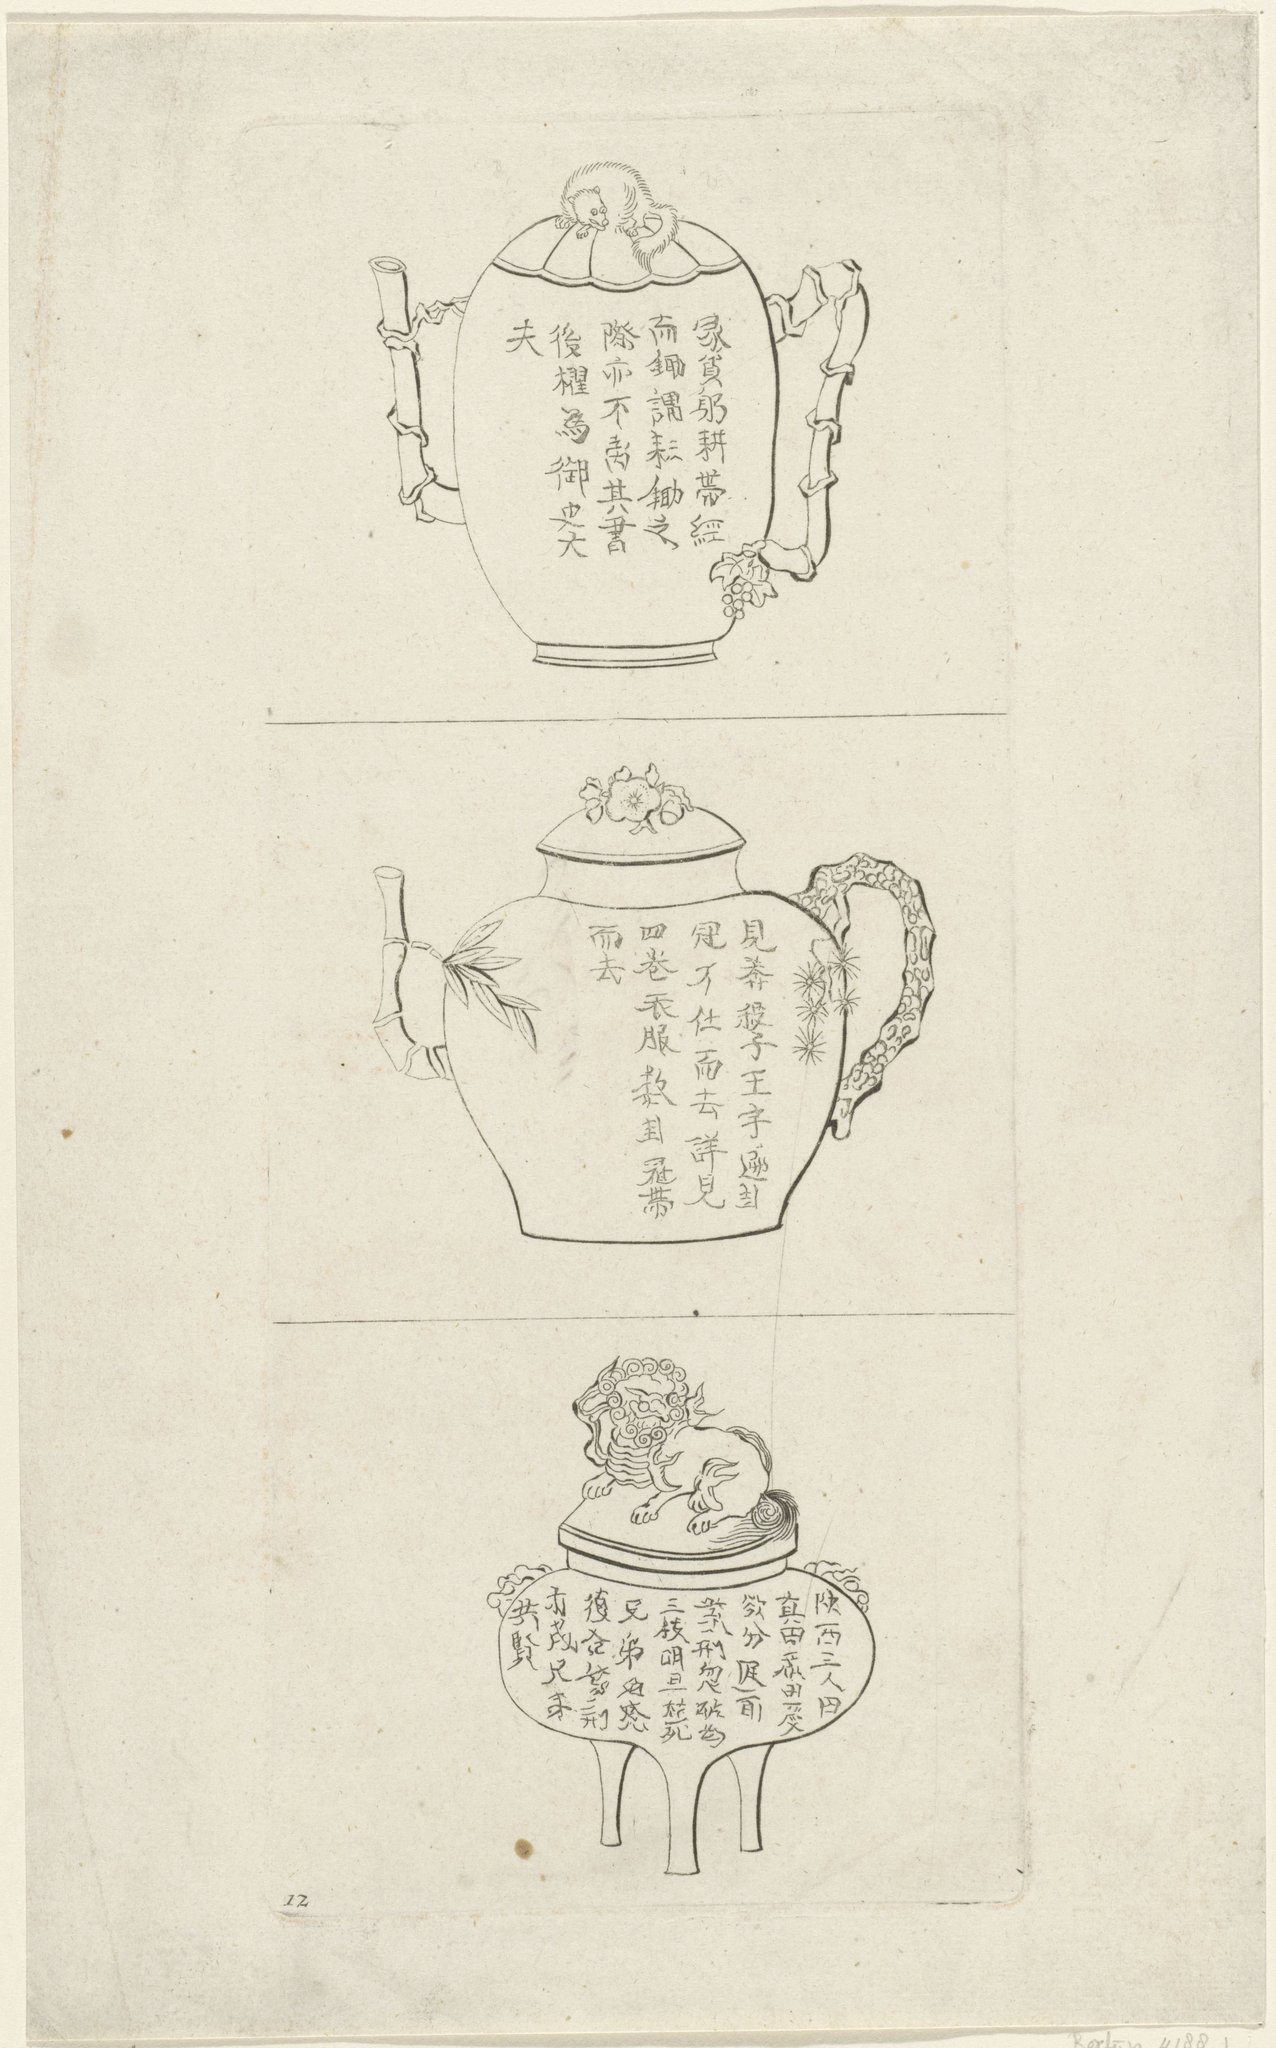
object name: print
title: Two Teapots and an Incense Burner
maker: pieter schenk (i)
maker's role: print maker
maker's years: 1660-1711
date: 1702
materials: paper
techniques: etching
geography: amsterdam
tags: tea-pot; samovar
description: Schenk the elder took great care to reproduce faithfully the Chinese characters on the bodies of three objects. The text on the teapot in the middle, for example, is the biography of T’ao Ch’ien, a Chinese poet who lived during the Eastern Jin (317-420 CE) and Liu Song (420-479 CE) dynasties. Below it, the incense burner describes the life of Ts’ao-wo, a young girl depicted in other prints from this set.